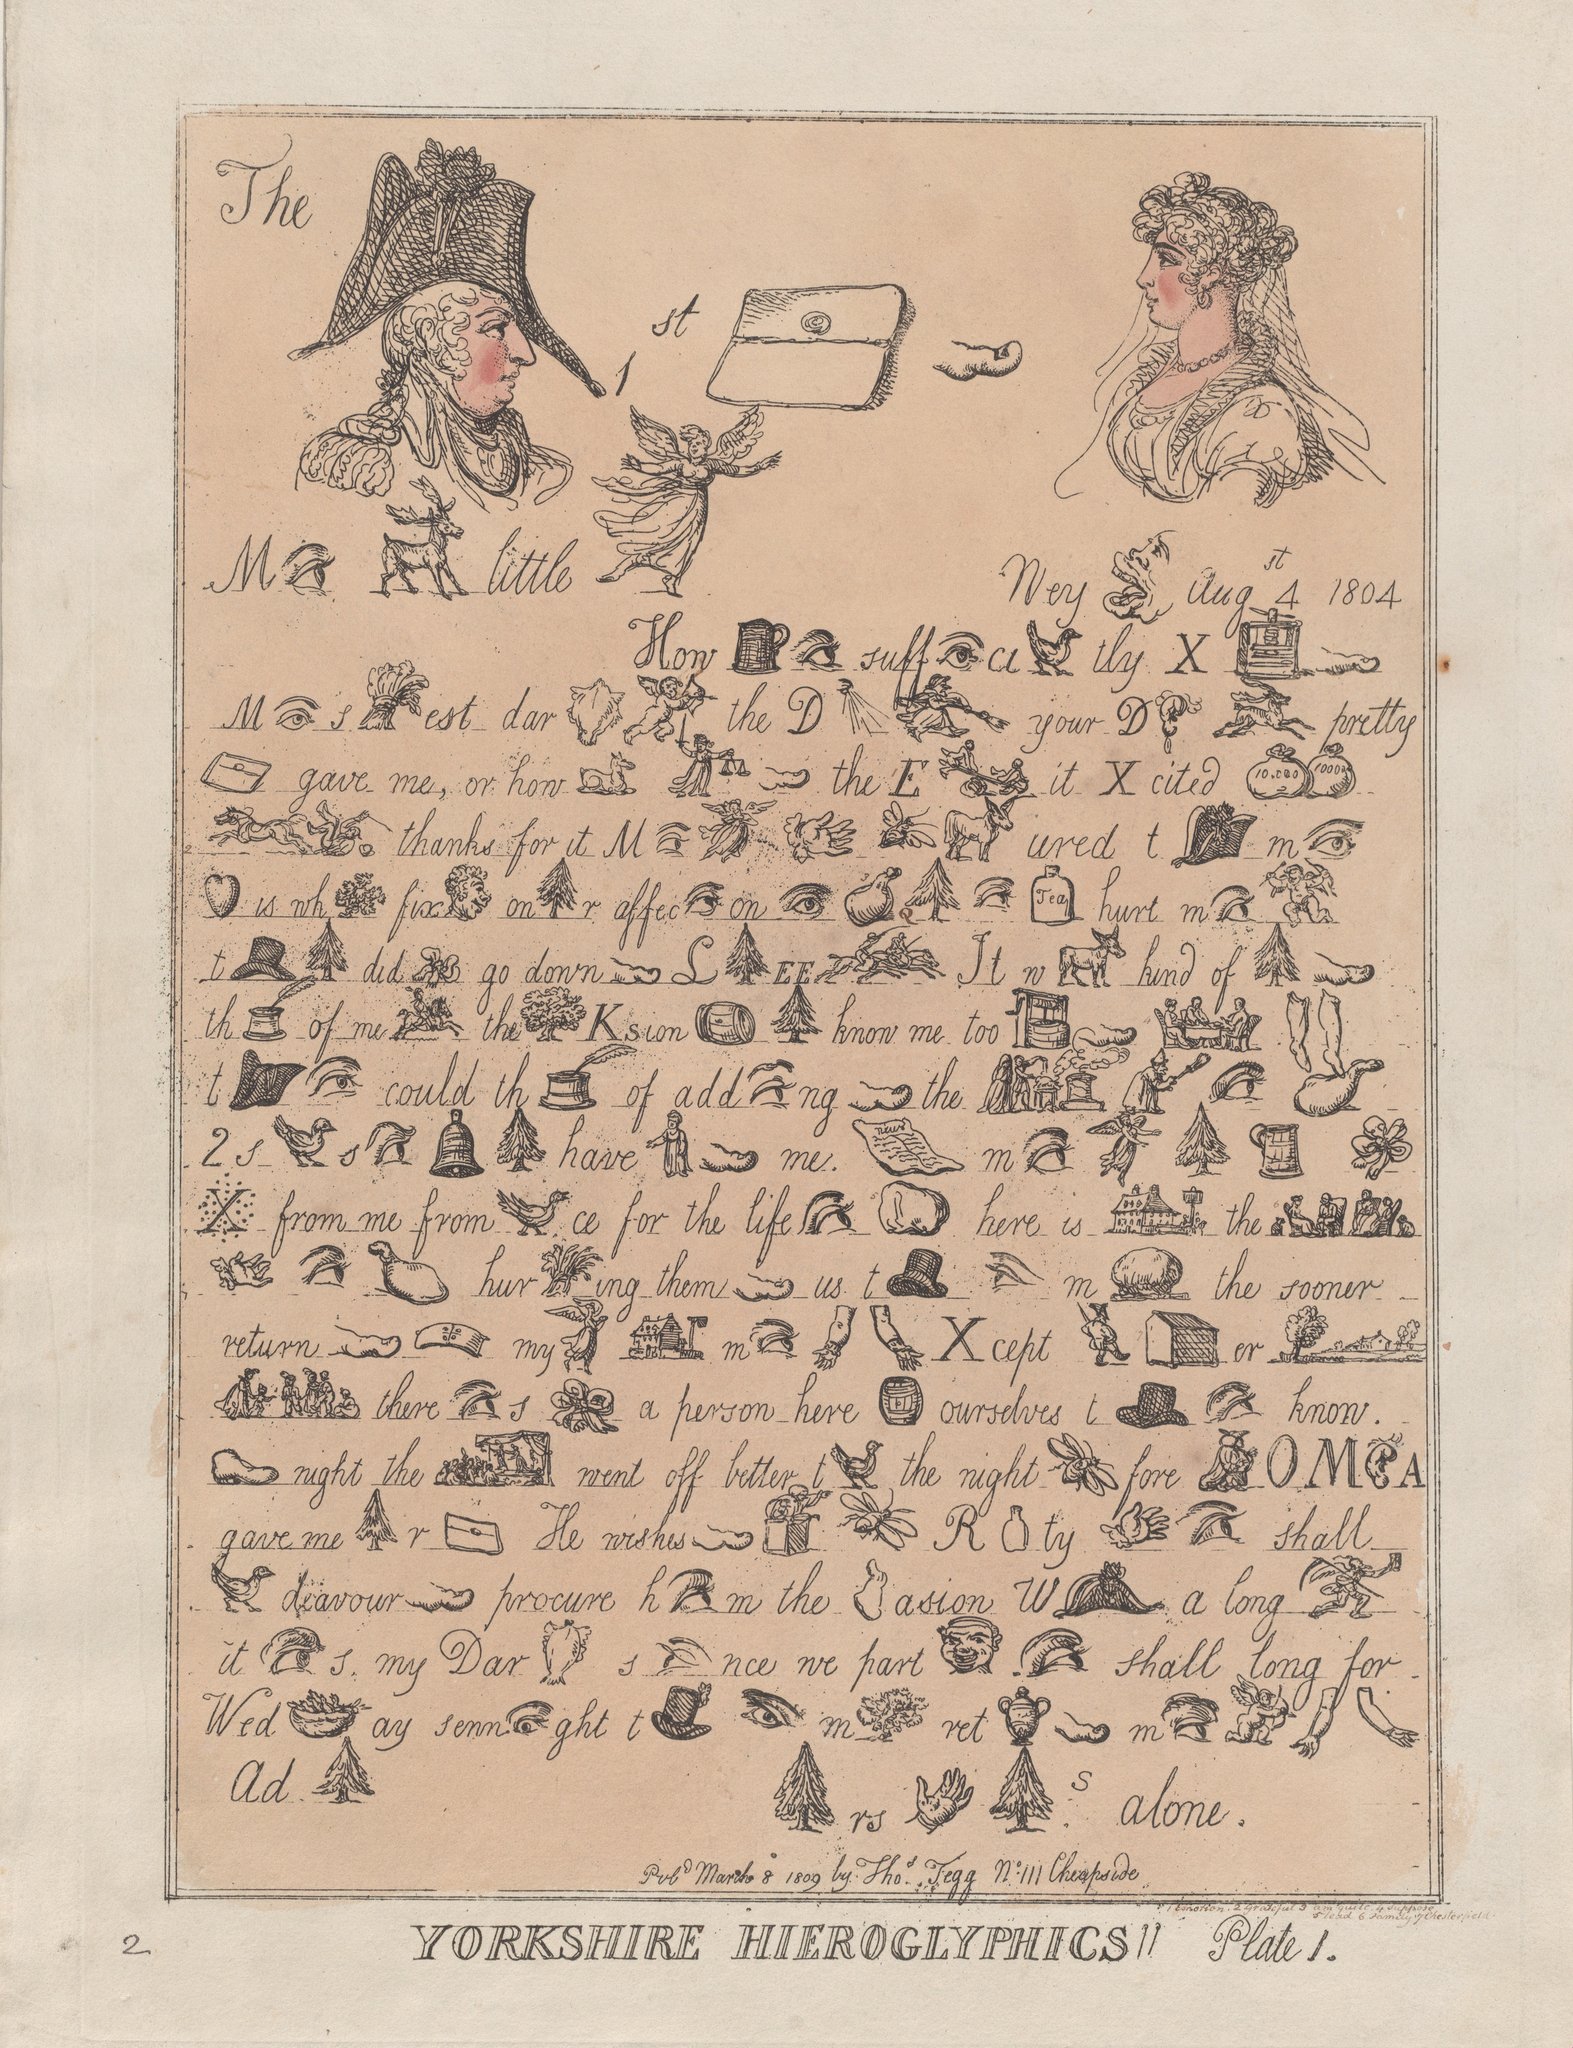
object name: print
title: Yorkshire Hieroglyphics, Plate 1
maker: thomas rowlandson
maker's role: artist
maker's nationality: british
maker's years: 1757-1827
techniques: etching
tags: satire,hieroglyphs,politics